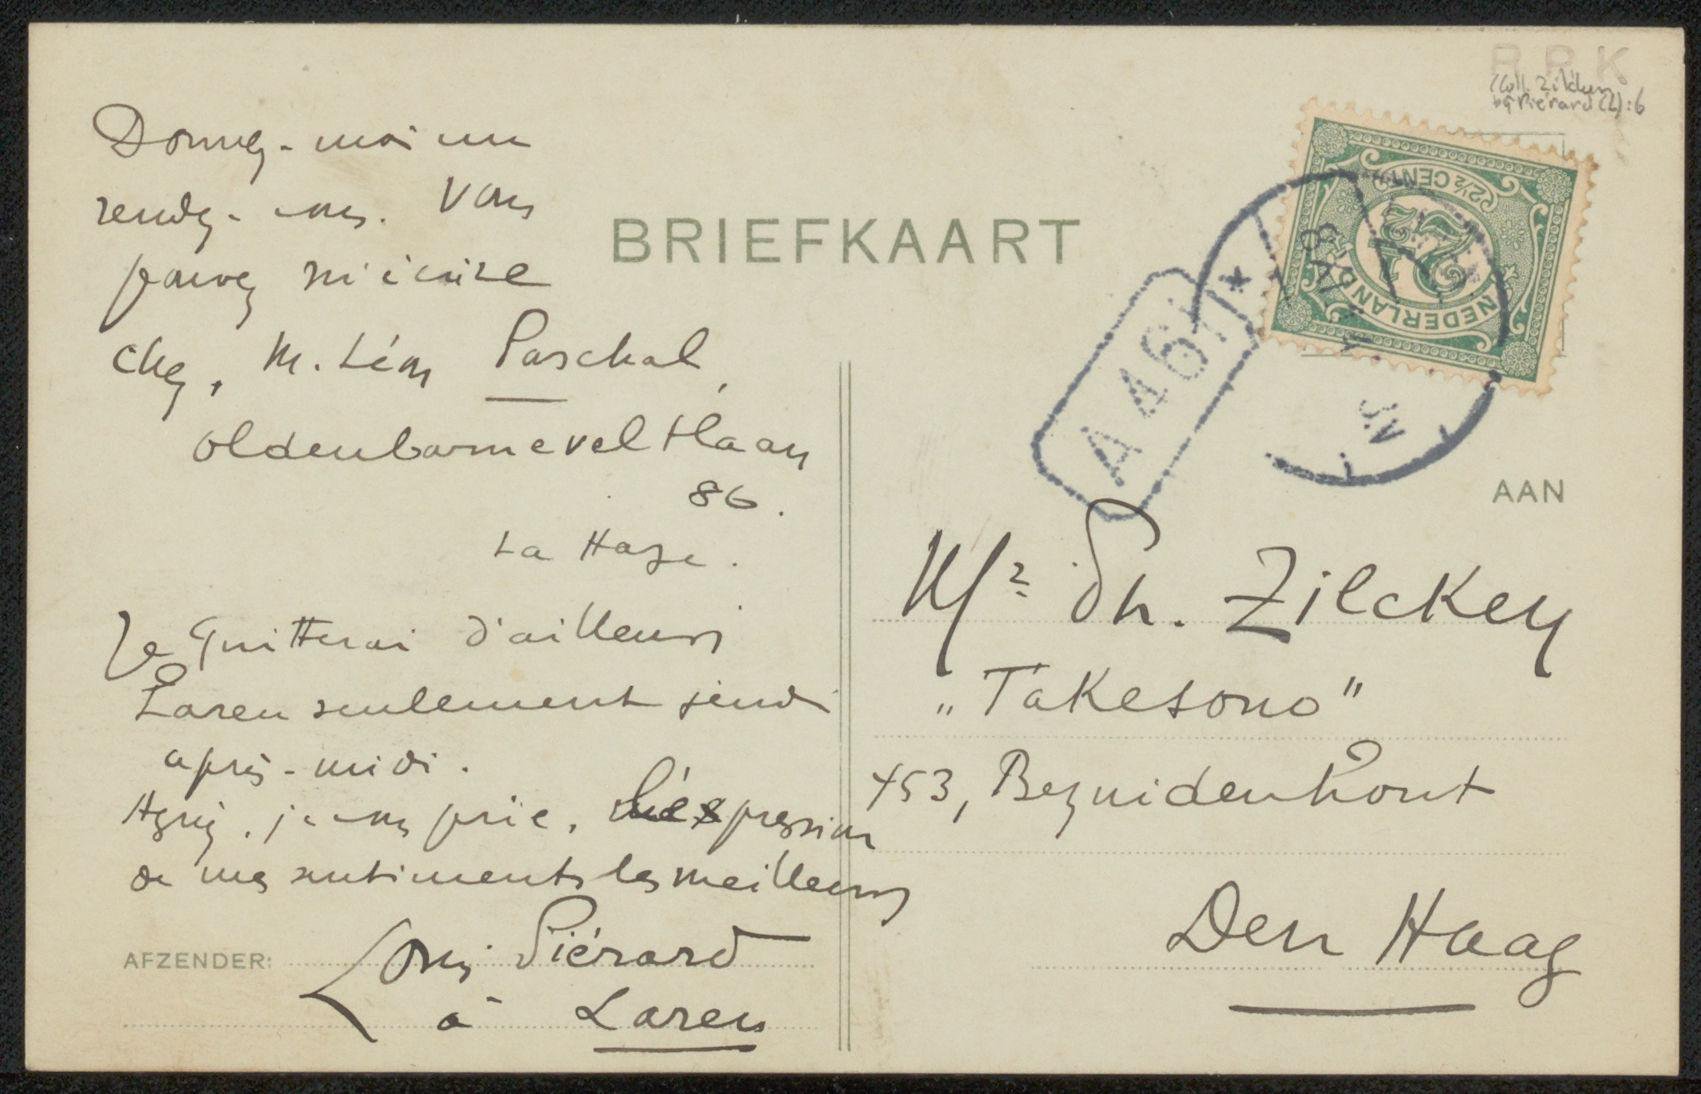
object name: postcard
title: Briefkaart aan Philip Zilcken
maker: louis piérard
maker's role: letterkundige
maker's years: 1886-1951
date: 1914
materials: cardboard, ink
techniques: pen, writing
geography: laren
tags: léon paschal, painter, draughtsman, philip zilcken, the hague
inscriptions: collector's mark: ‘RPK’